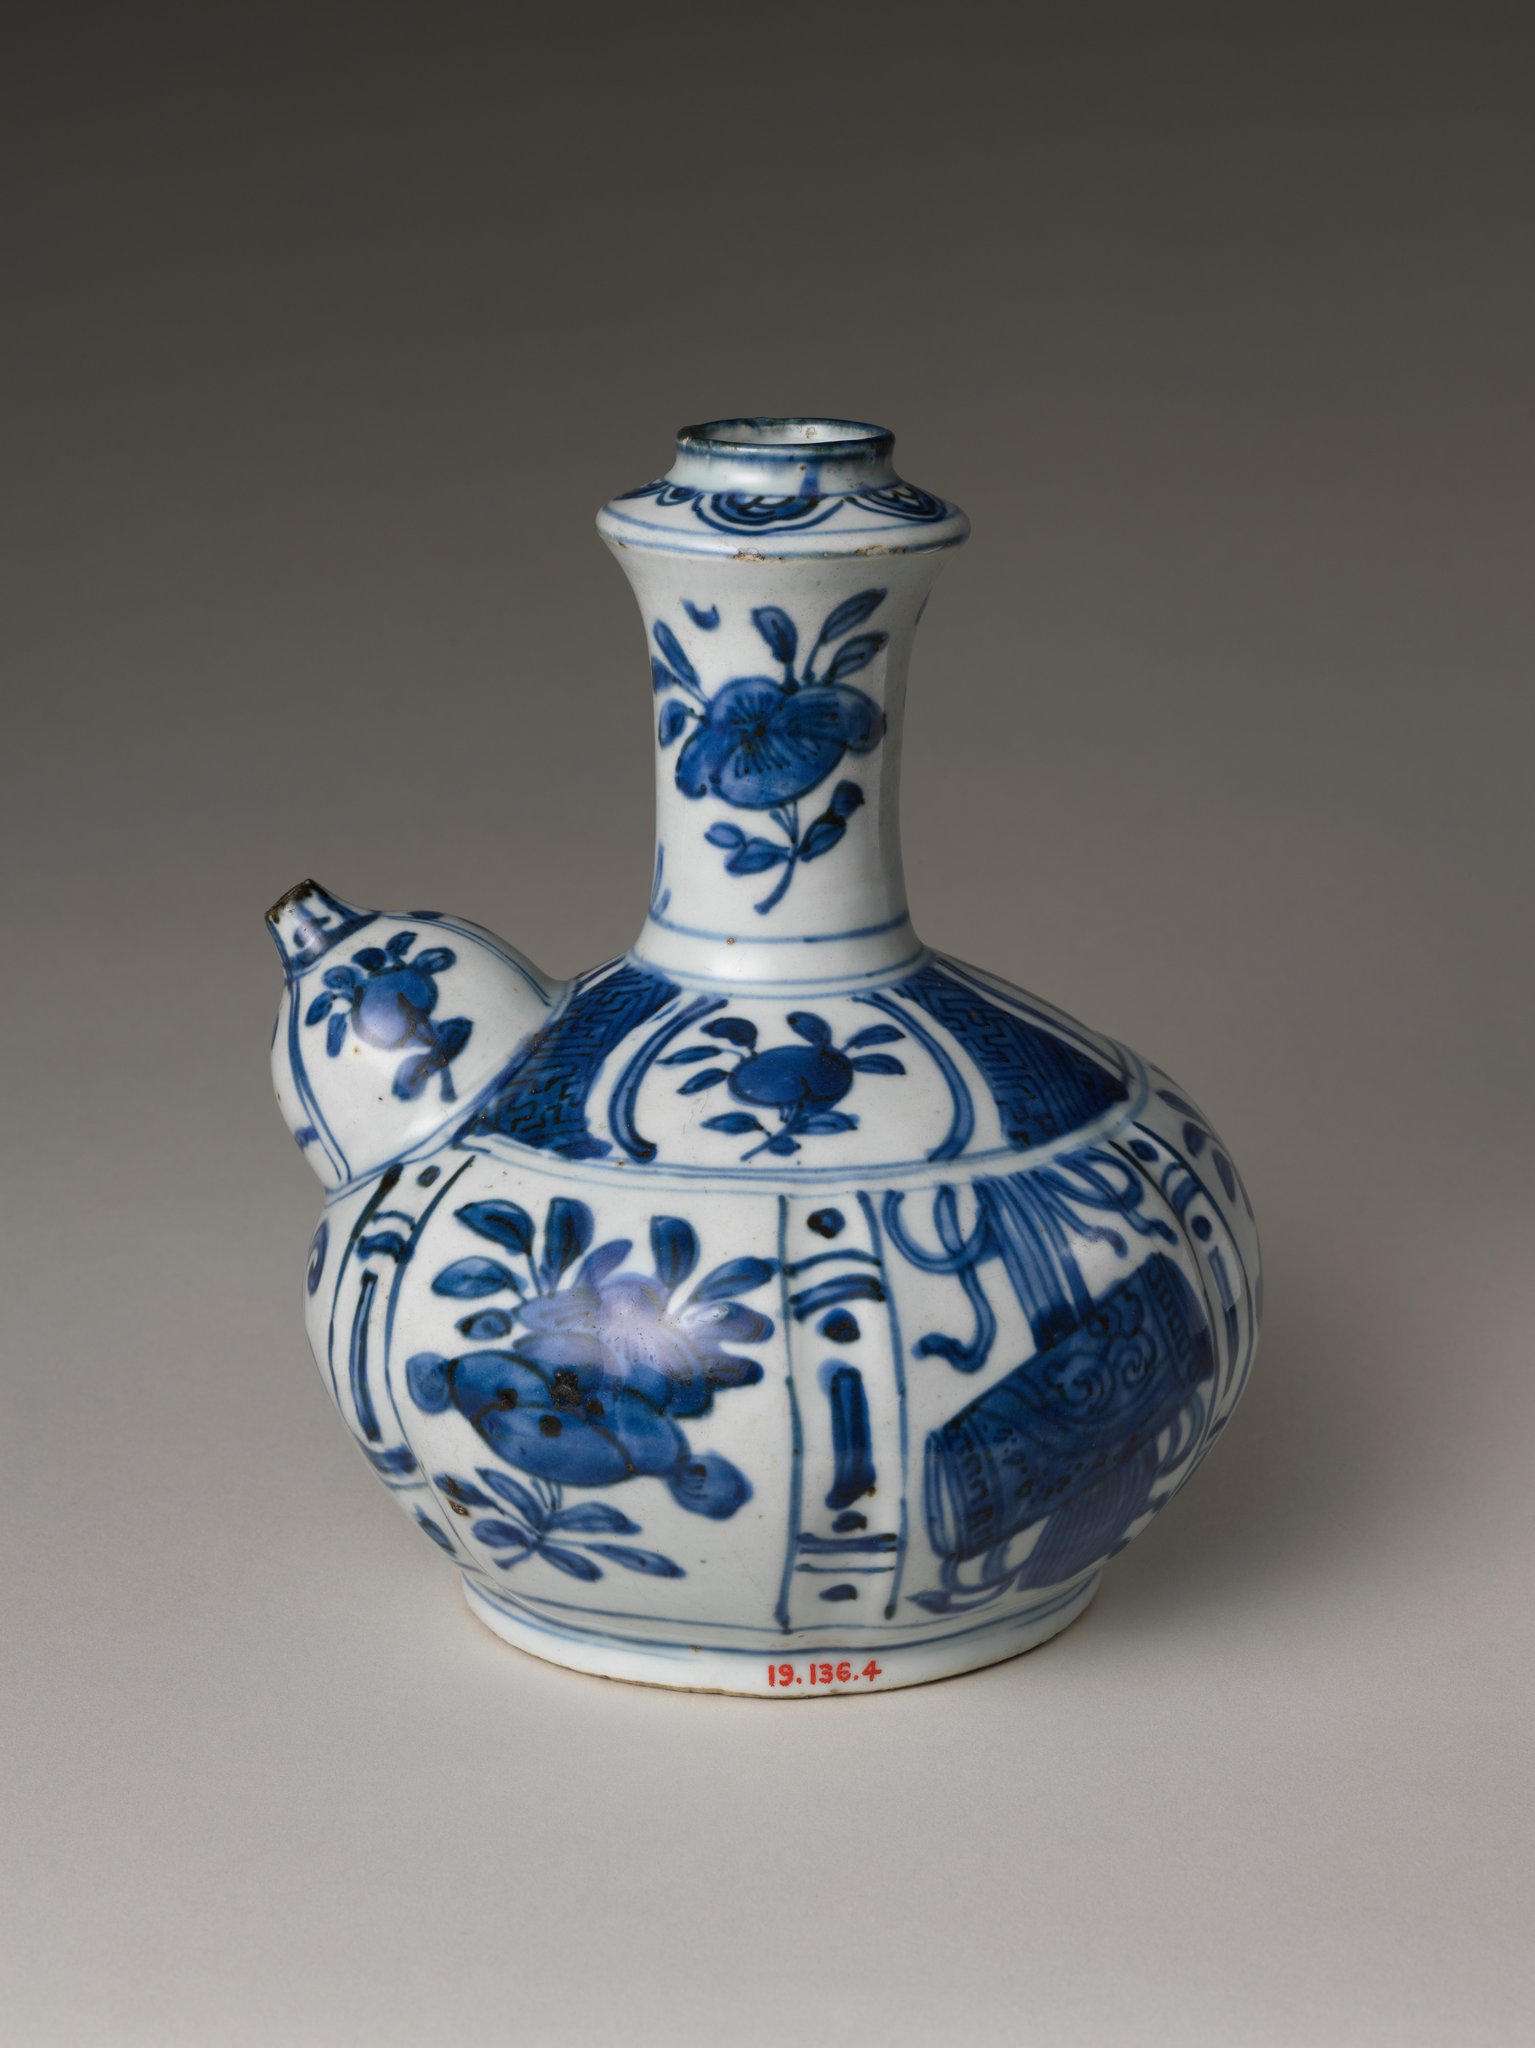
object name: kendi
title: Pouring Vessel (Kendi) with Flowers and Fruits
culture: chinese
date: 1567-1600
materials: cobalt, glaze, porcelain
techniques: painting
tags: fruit,flowers